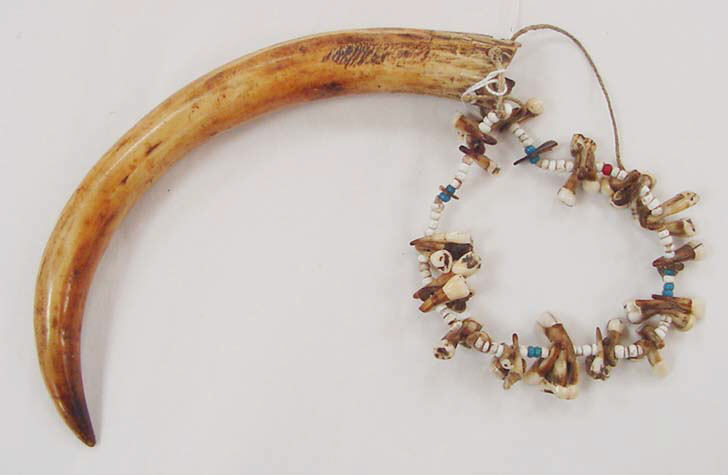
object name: necklace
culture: indian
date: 1801-1900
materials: bone, cotton, glass